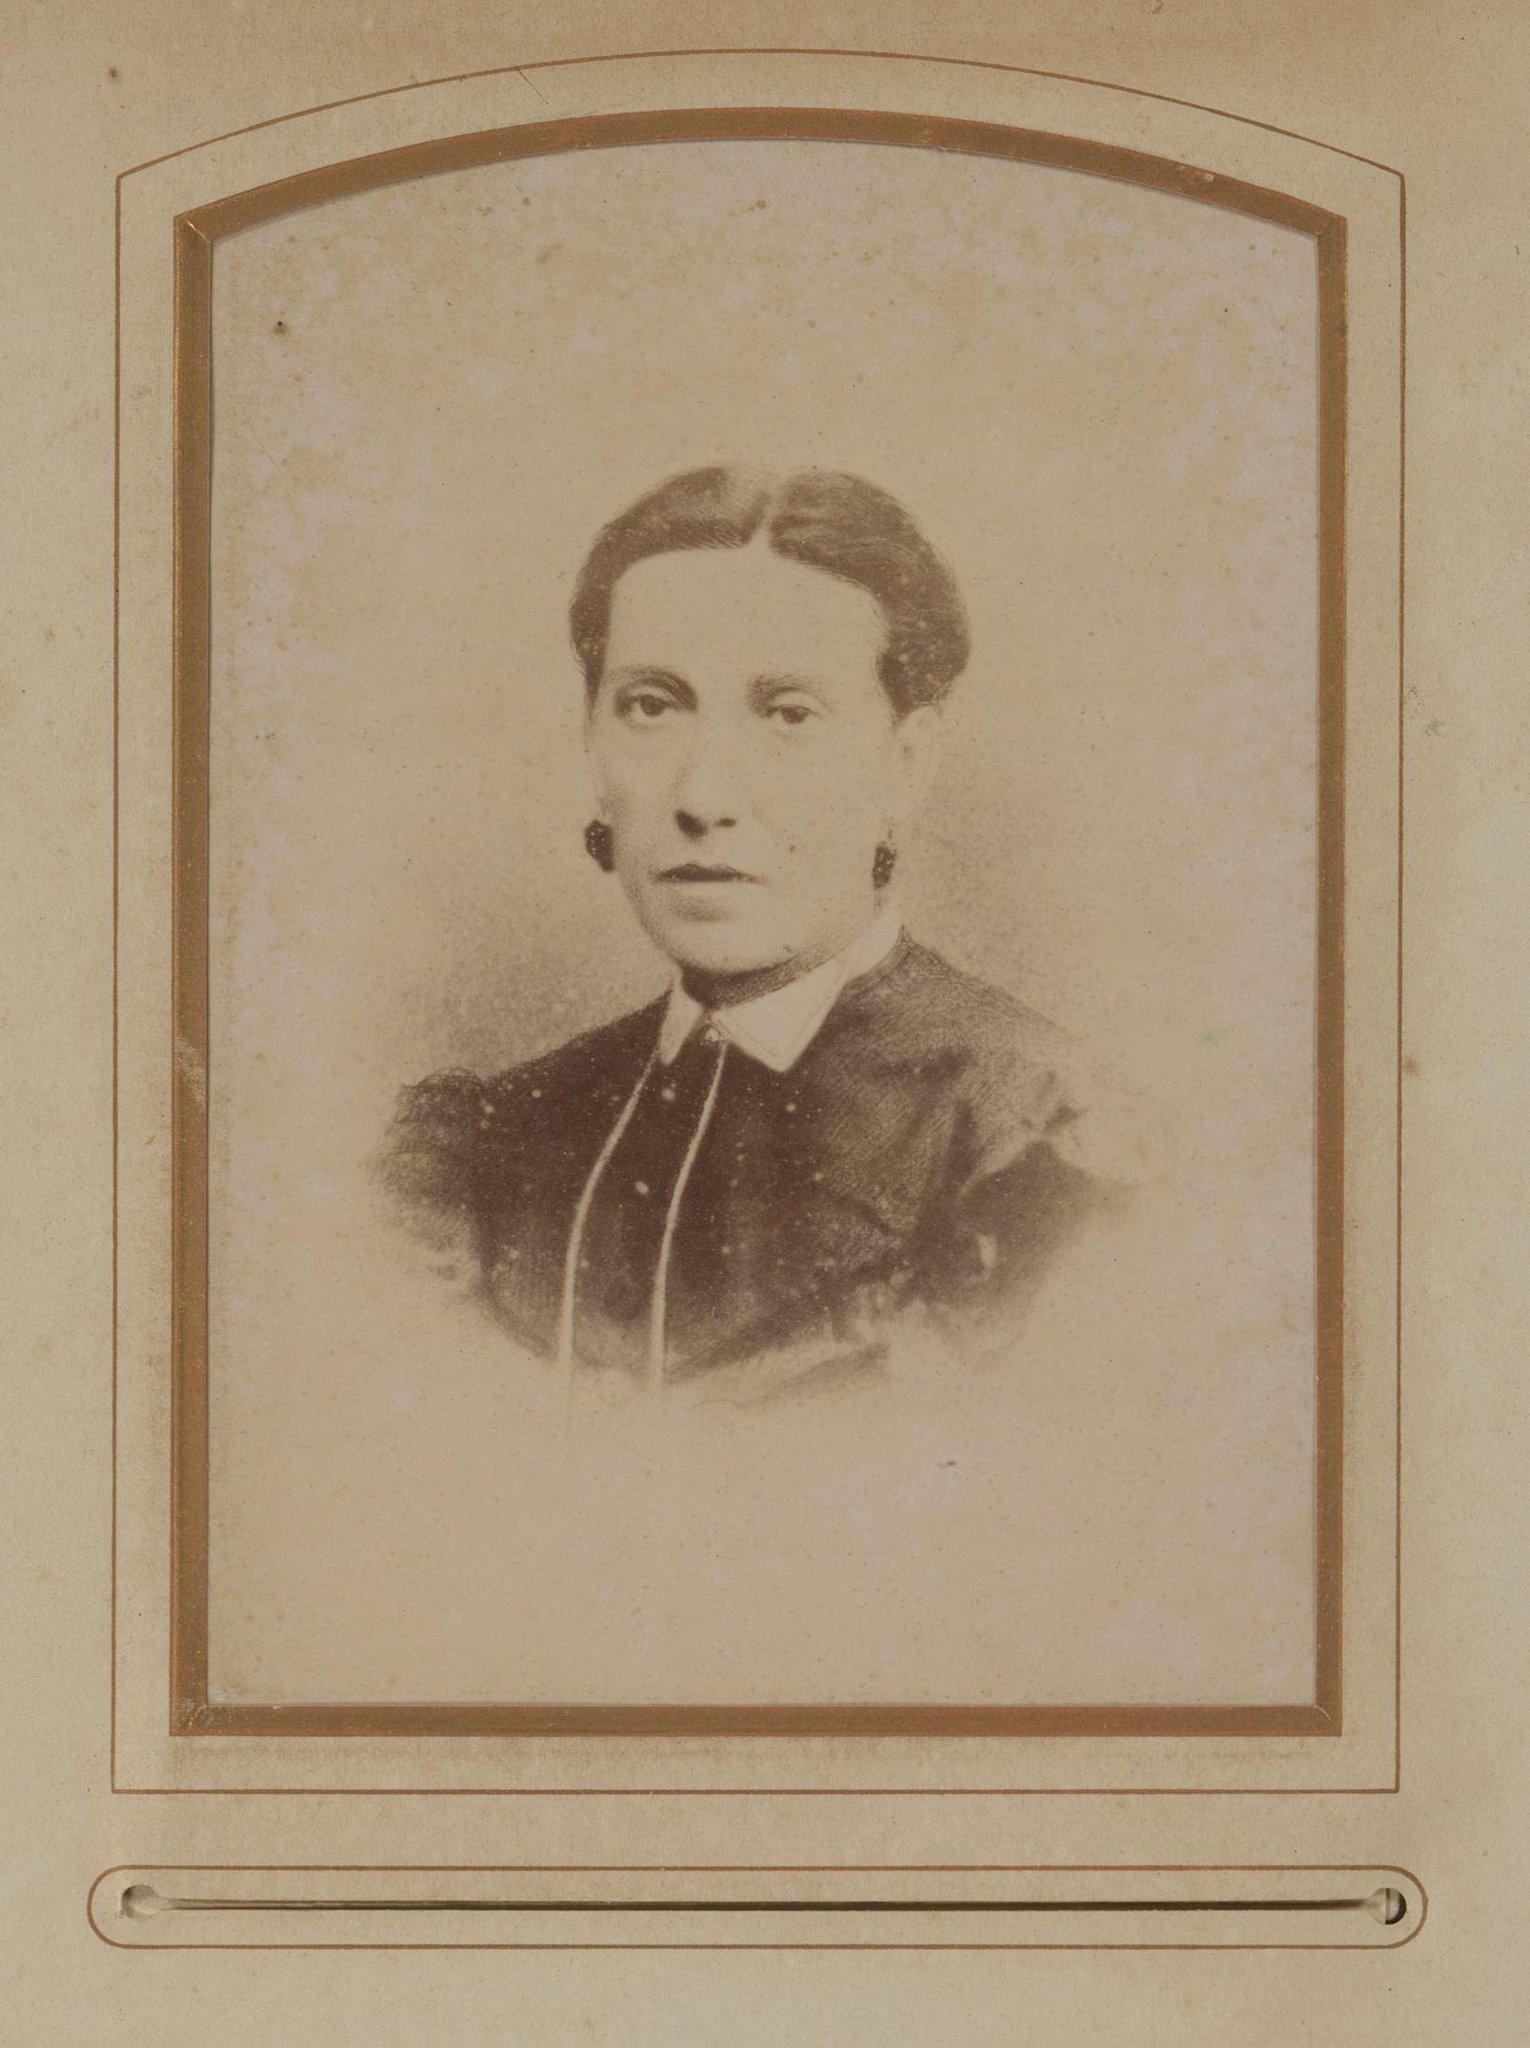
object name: cabinet photograph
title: Portret van een vrouw met oorbellen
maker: Anonymous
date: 1860-1900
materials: cardboard, photographic support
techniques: albumen print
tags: historical persons - bb - woman, ear-rings